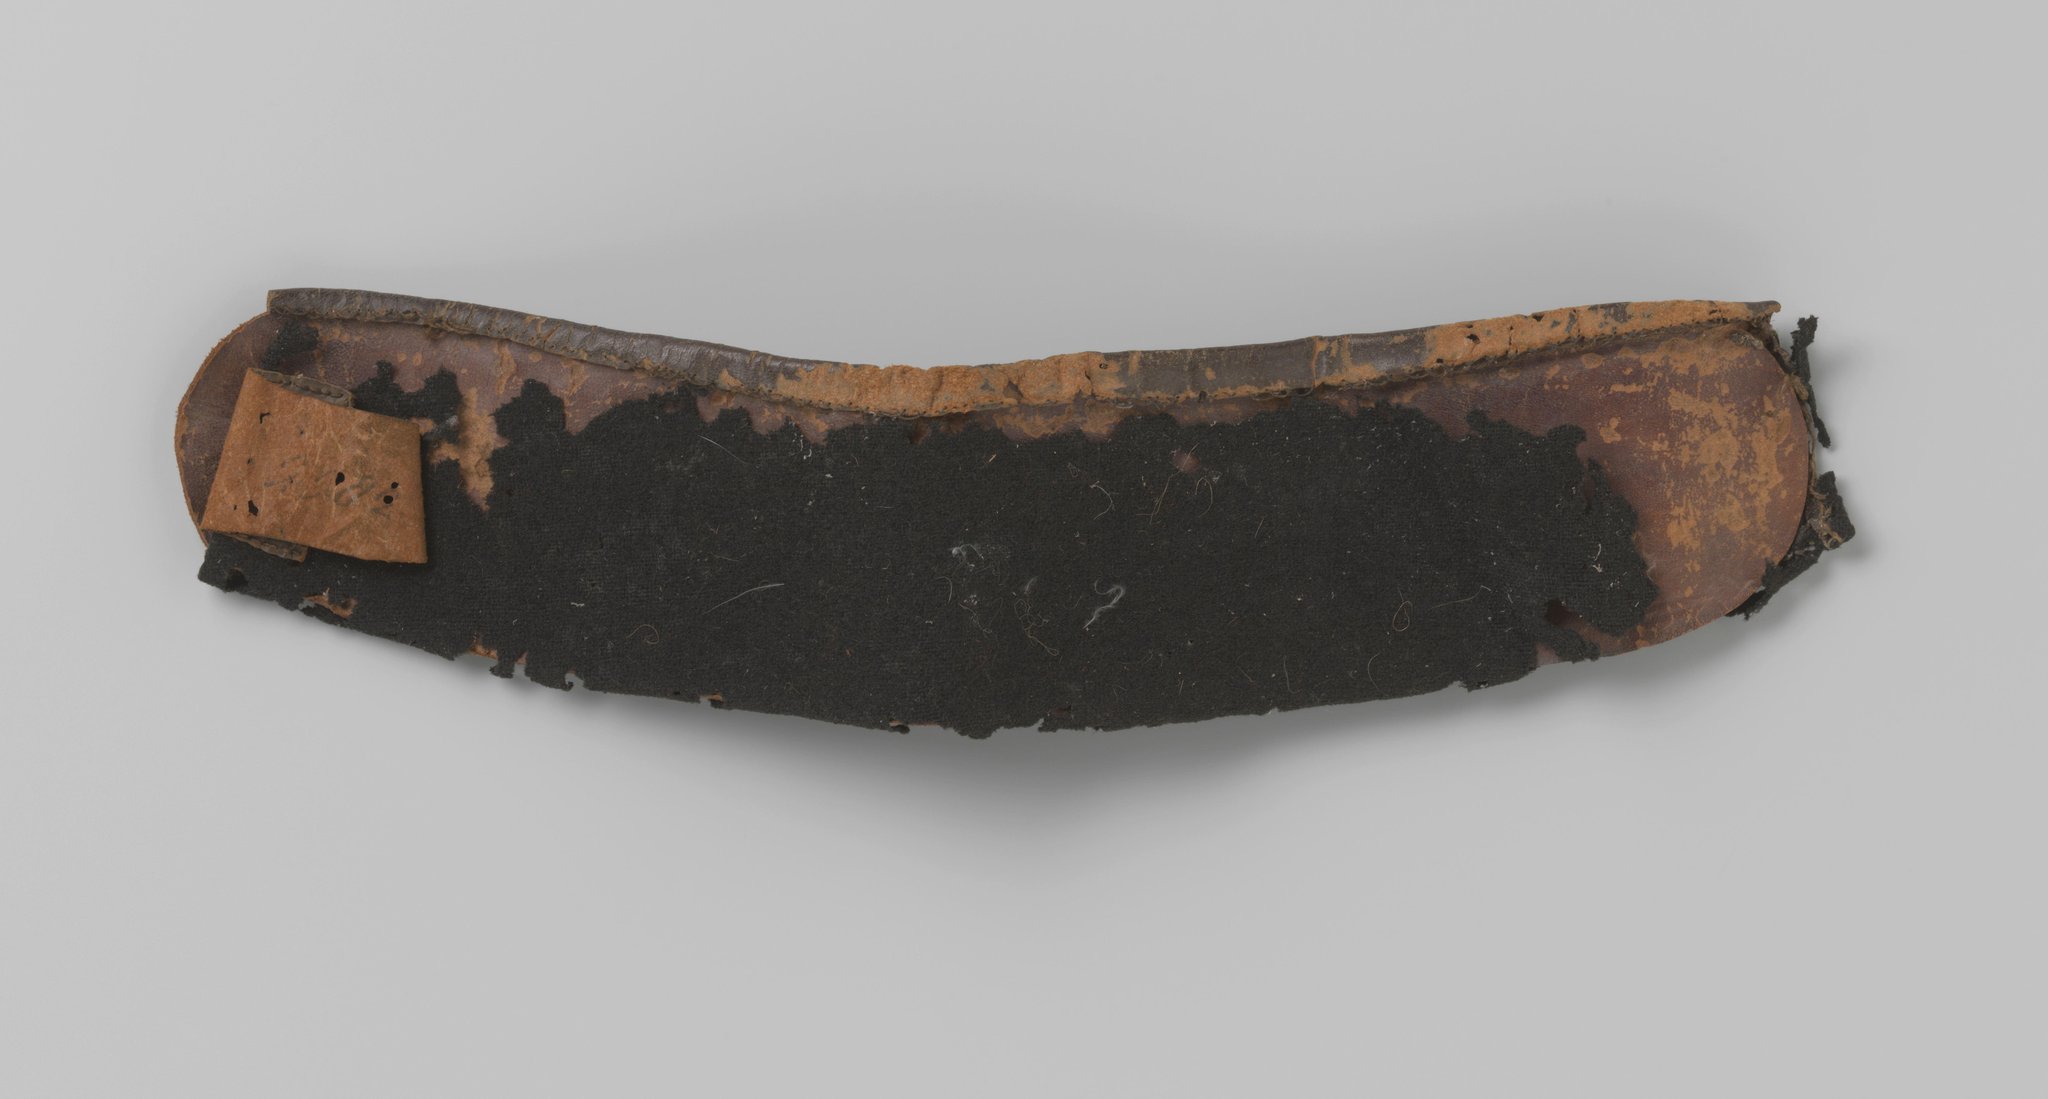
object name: collar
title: Kraag van mouwvest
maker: Anonymous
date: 1830-1831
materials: felt, leather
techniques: stitching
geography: netherlands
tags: netherlands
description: Kraag van vilt behorende bij de mouwvest. De randen van de kraag zijn van leer.